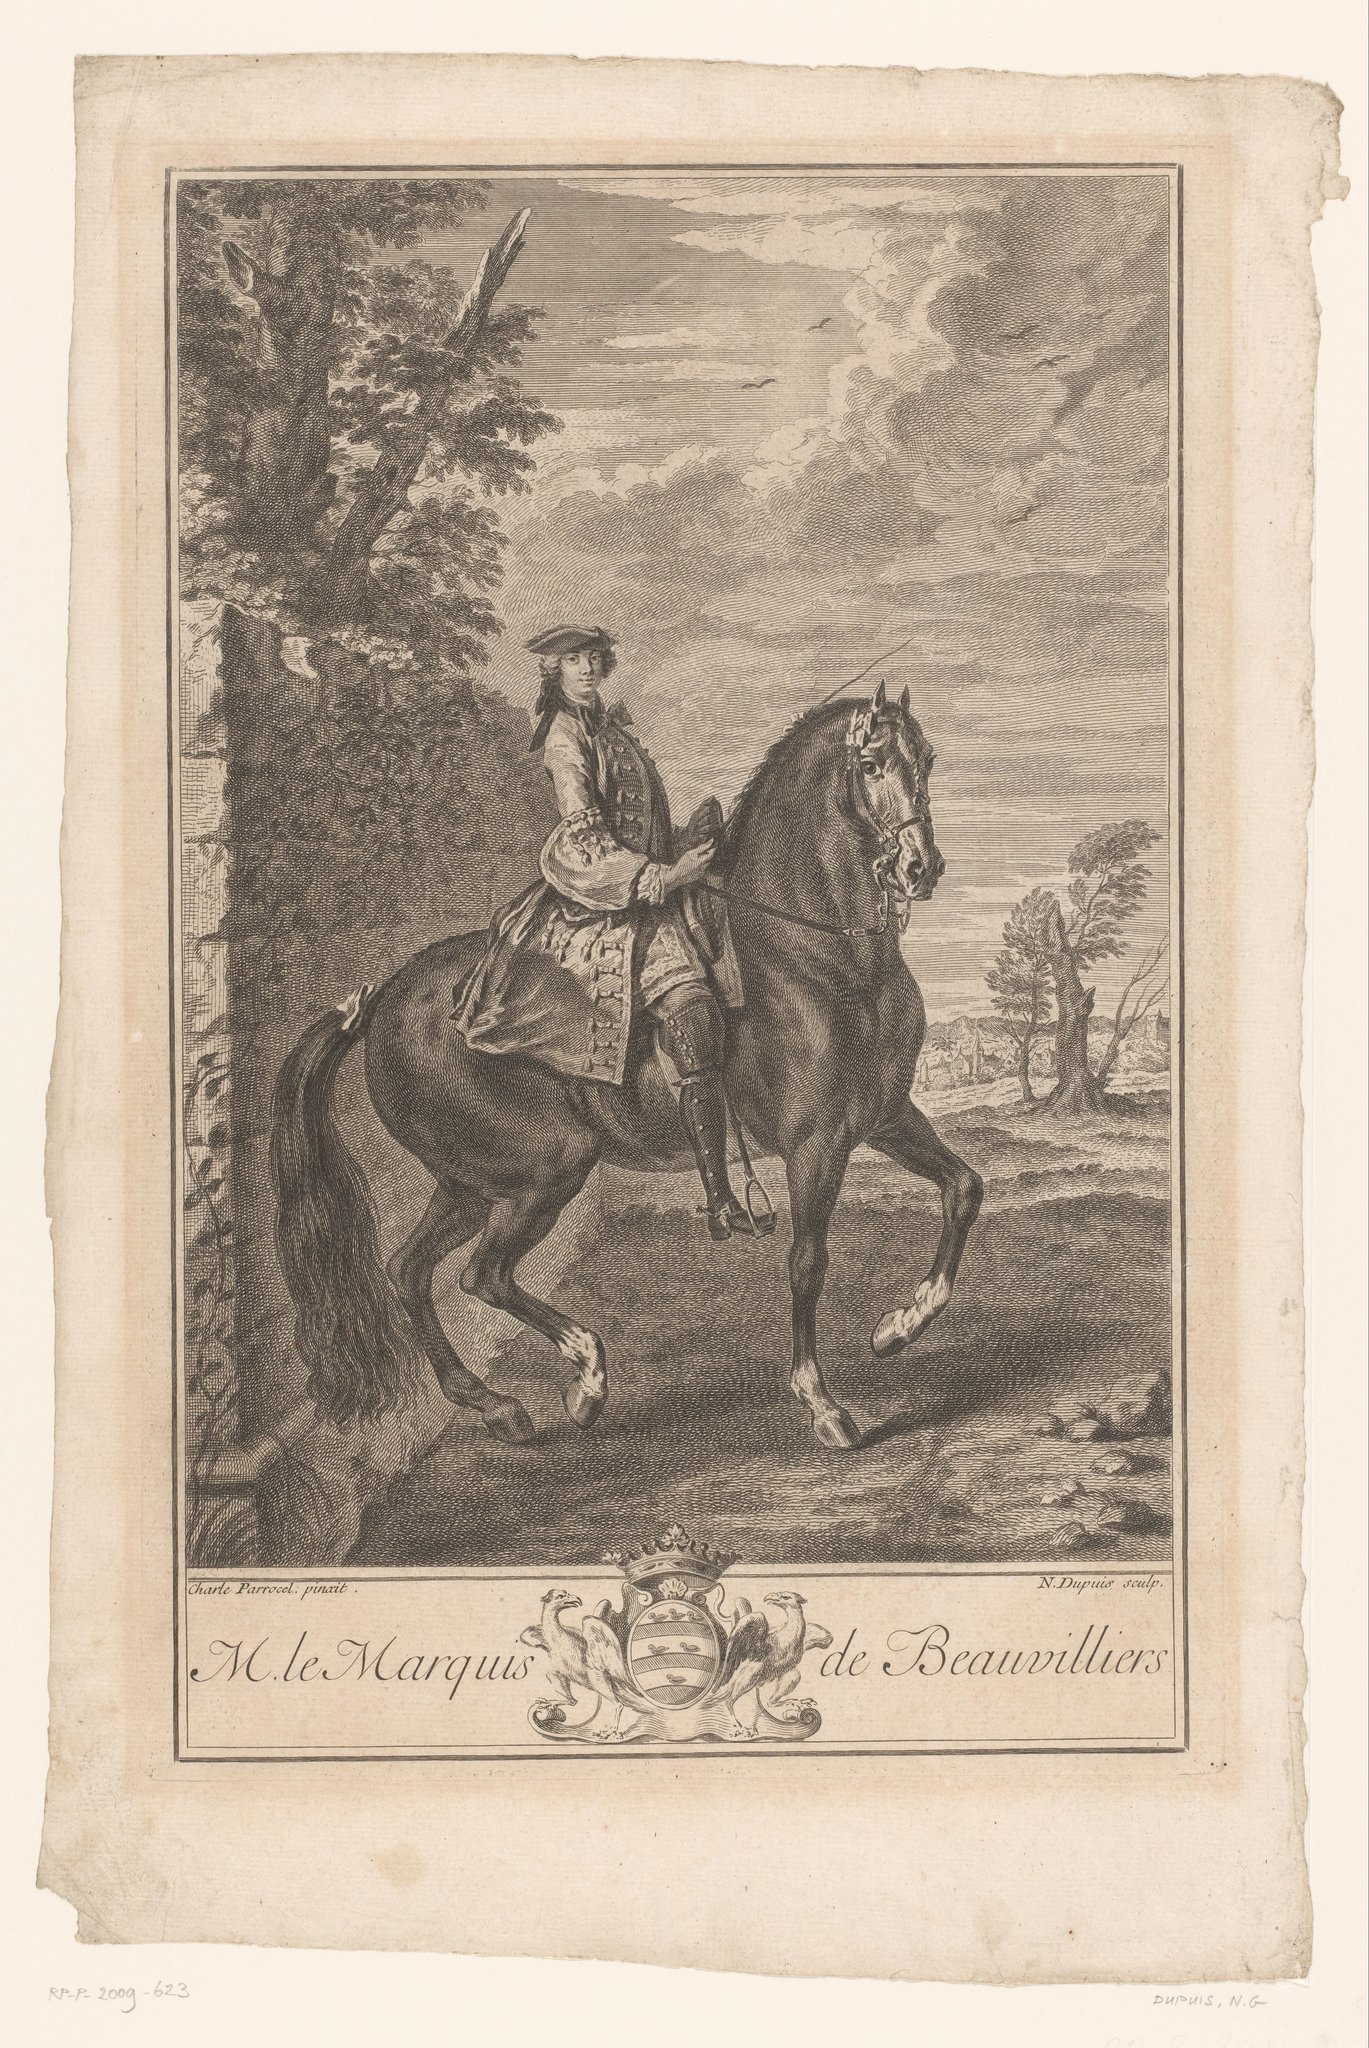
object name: print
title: M. le Marquis de Beauvilliers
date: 1733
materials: paper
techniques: engraving, etching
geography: paris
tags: high-school riding, armorial bearing, heraldry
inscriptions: collector's mark: Lugt 2228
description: Prent uit: Gueriniere, François Robichon de La. École de cavalerie: contenant la connoissance, l'instruction et la conservation du cheval. Parijs: Jacques Guerrin, 1733, p. 109.